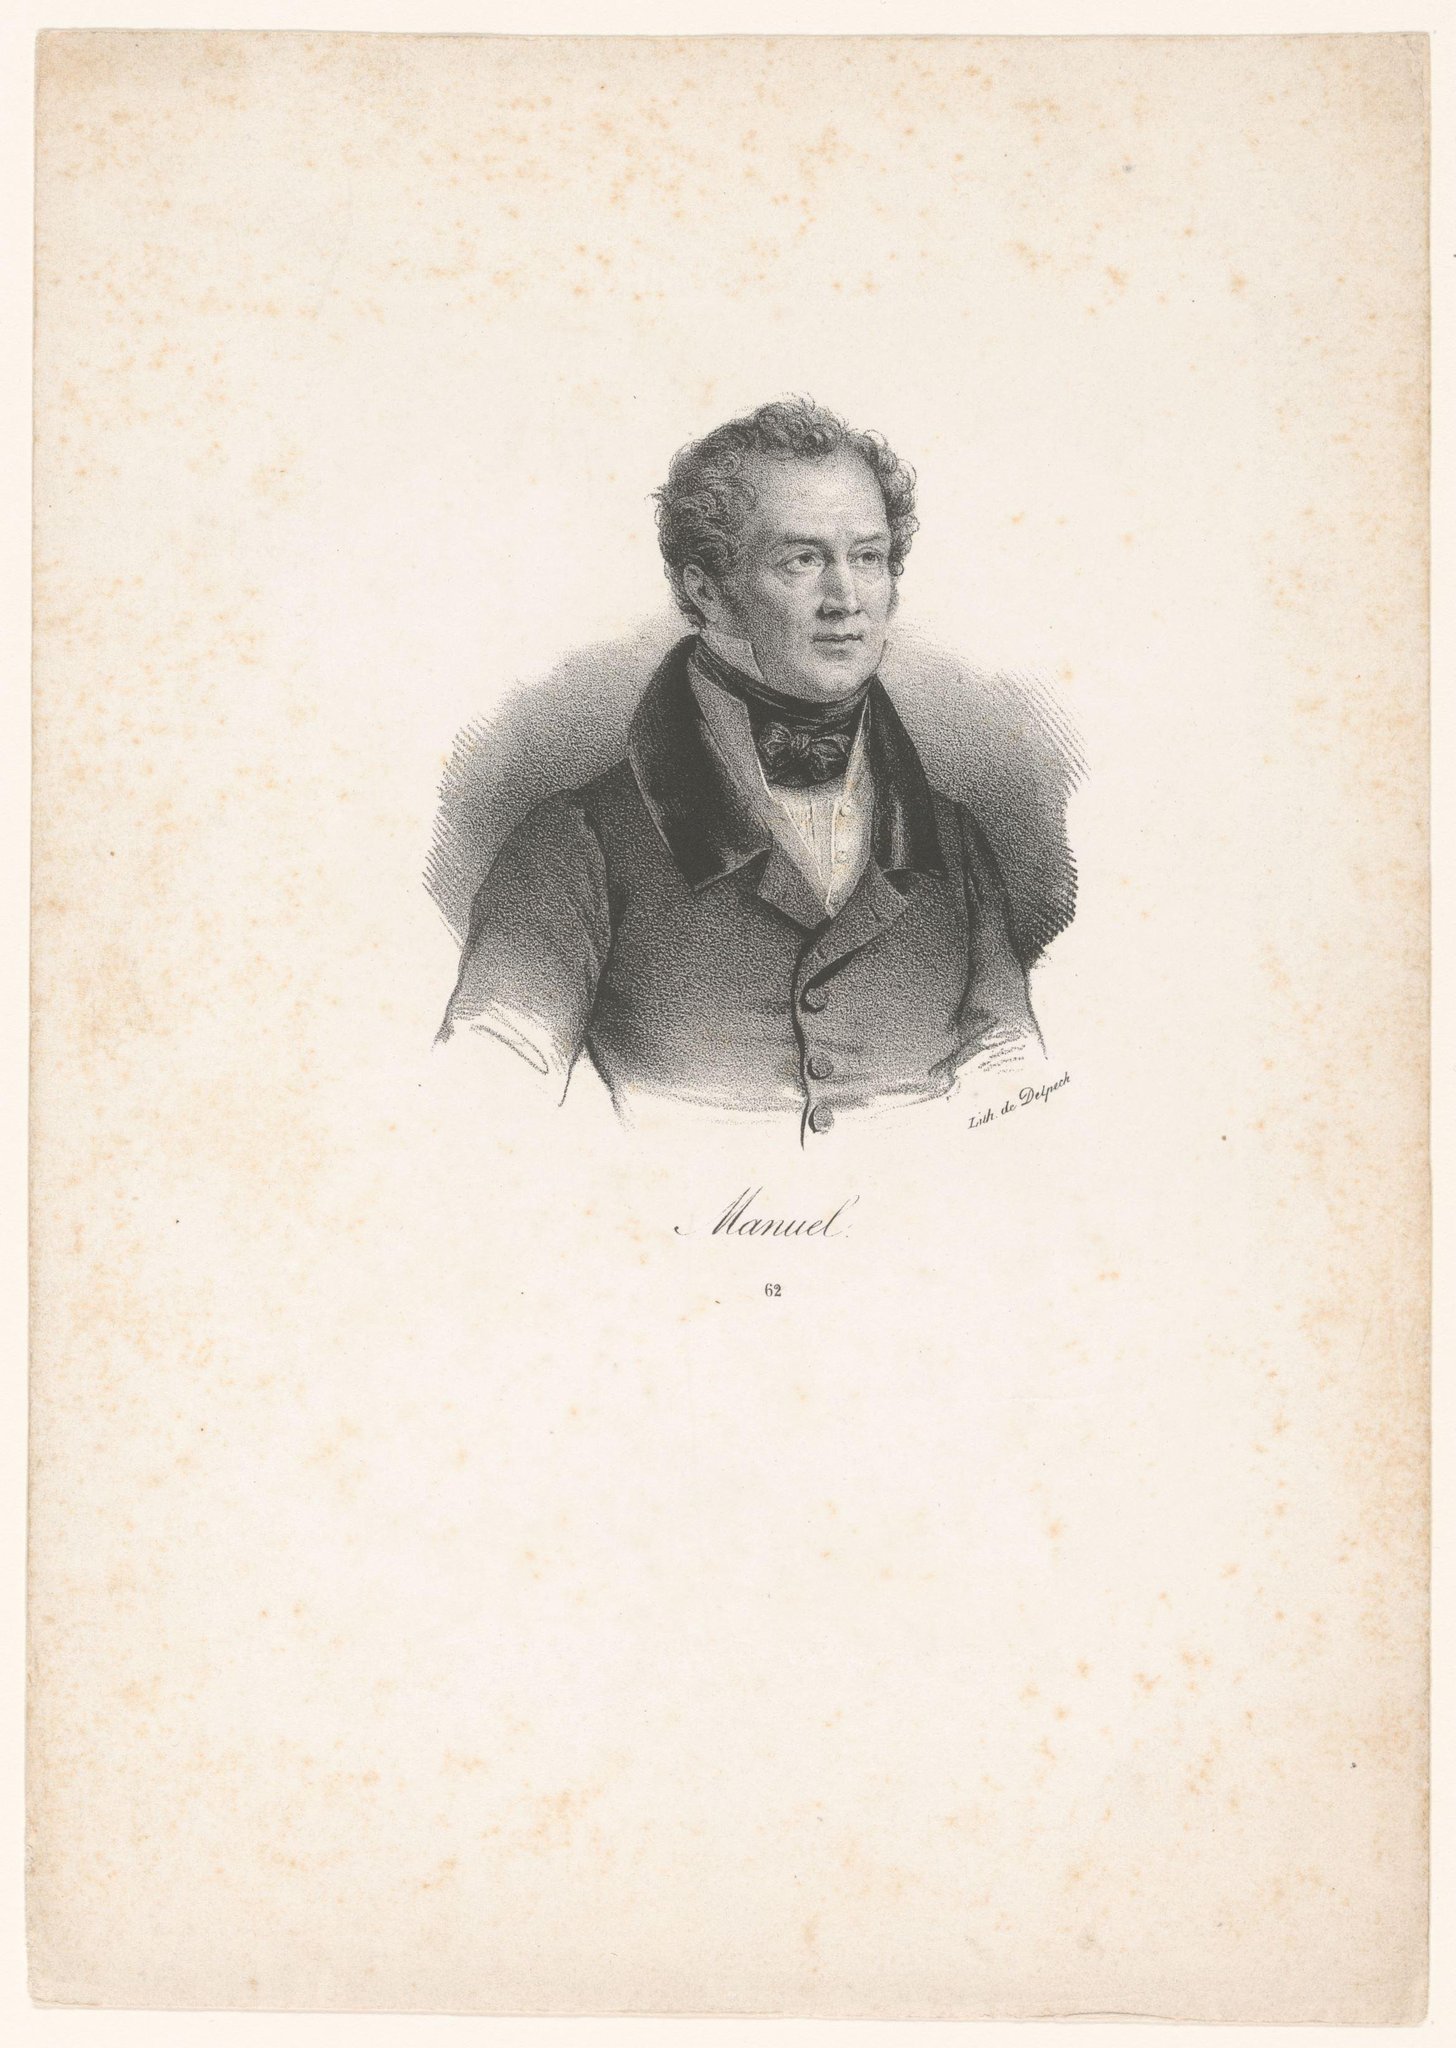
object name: print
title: Manuel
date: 1818-1842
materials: paper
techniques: lithograph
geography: paris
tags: politician, historical persons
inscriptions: collector's mark: Lugt 2228a